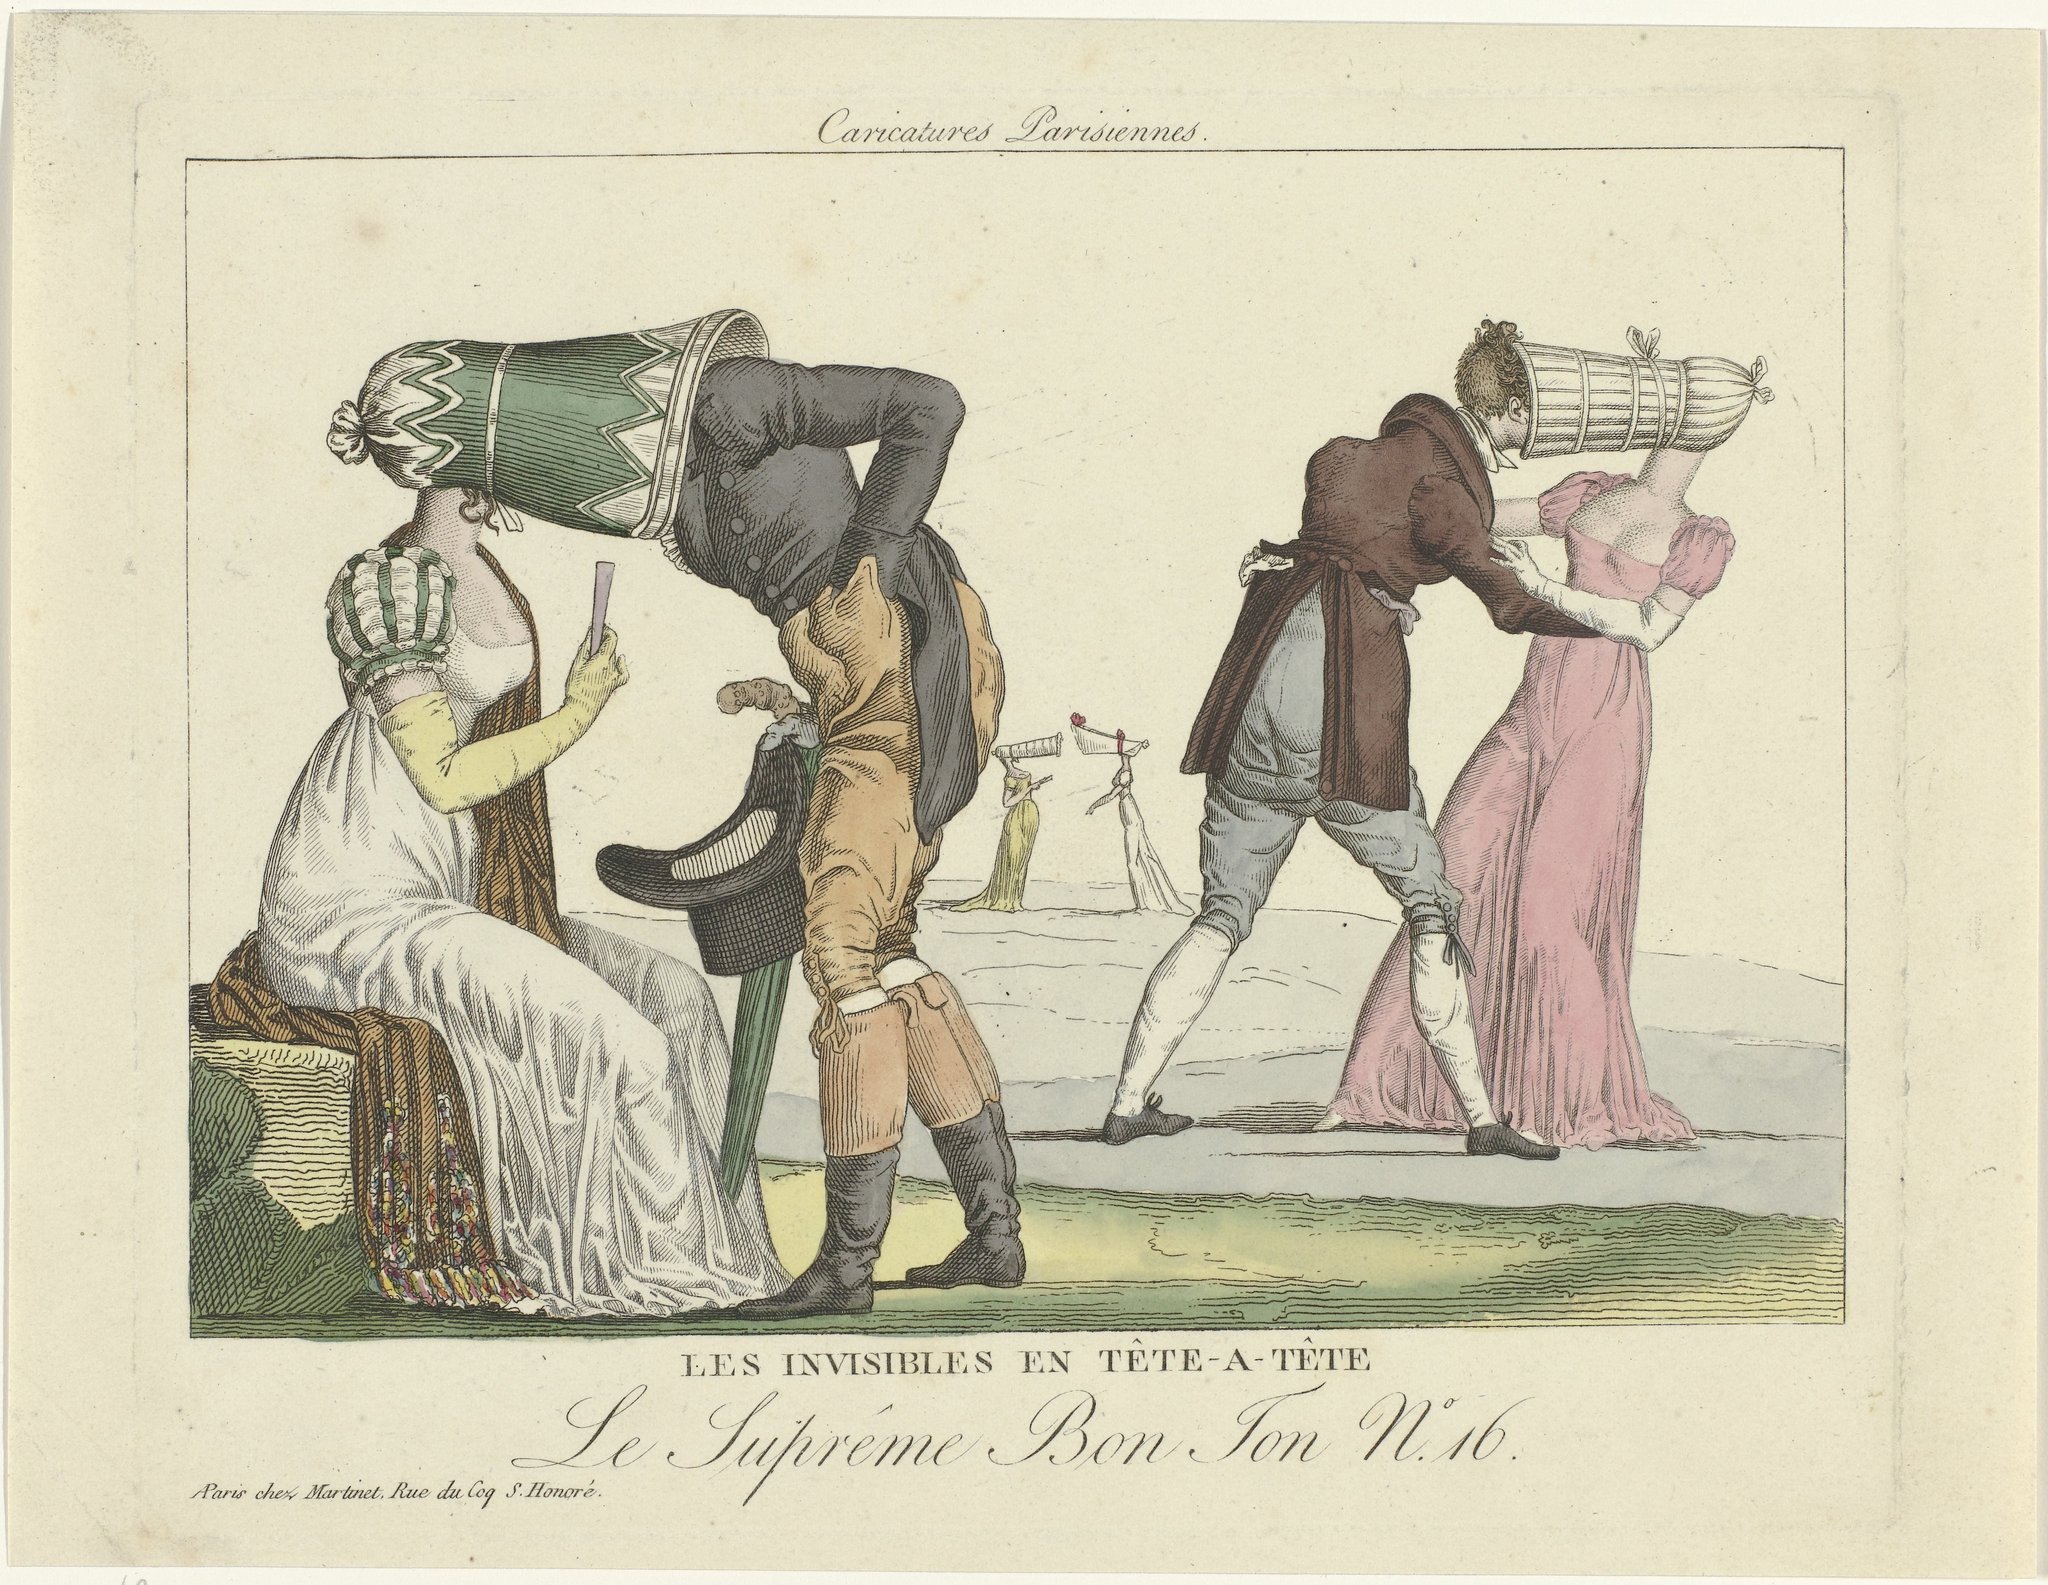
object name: cartoon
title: Le Supreme Bon Ton, Caricatures Parisiennes, 1800-1815, No.16: Les invisibles en tête-a-tête.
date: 1800-1815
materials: paper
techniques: etching, hand coloring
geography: paris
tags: head-gear (poke bonnet) (+ women's clothes), head-gear (capote) (+ women's clothes), gloves, mittens (long gloves) (+ women's clothes), clothing for the upper part of the body (shawl) (+ women's clothes), coat (+ men's clothes), head-gear: hat (+ men's clothes), fashion plates, dress, gown (+ women's clothes), trousers, breeches, etc. (breeches) (+ men's clothes), boots (+ men's clothes), walking-stick, staff, cane (+ men's clothes)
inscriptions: title: ‘Le Suprême Bon Ton, No. 16.’, title: ‘Caricatures Parisiennes.’, address: ‘A Paris chez Martinet, Rue du Coq S. Honoré.’, caption: ‘LES INVISIBLES EN TÊTE-A-TÊTE’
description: Karikatuur op de grote luifelhoeden die in de mode waren rond 1800-1815. Twee modieus geklede stellen, waarbij het hoofd van de man 'verdwijnt' in de hoed van de vrouw. Op het derde plan twee vrouwen met idem hoeden. Prent uit een serie van 30 modeprenten, Le Suprême Bon Ton, Parijs, 1800-1815.